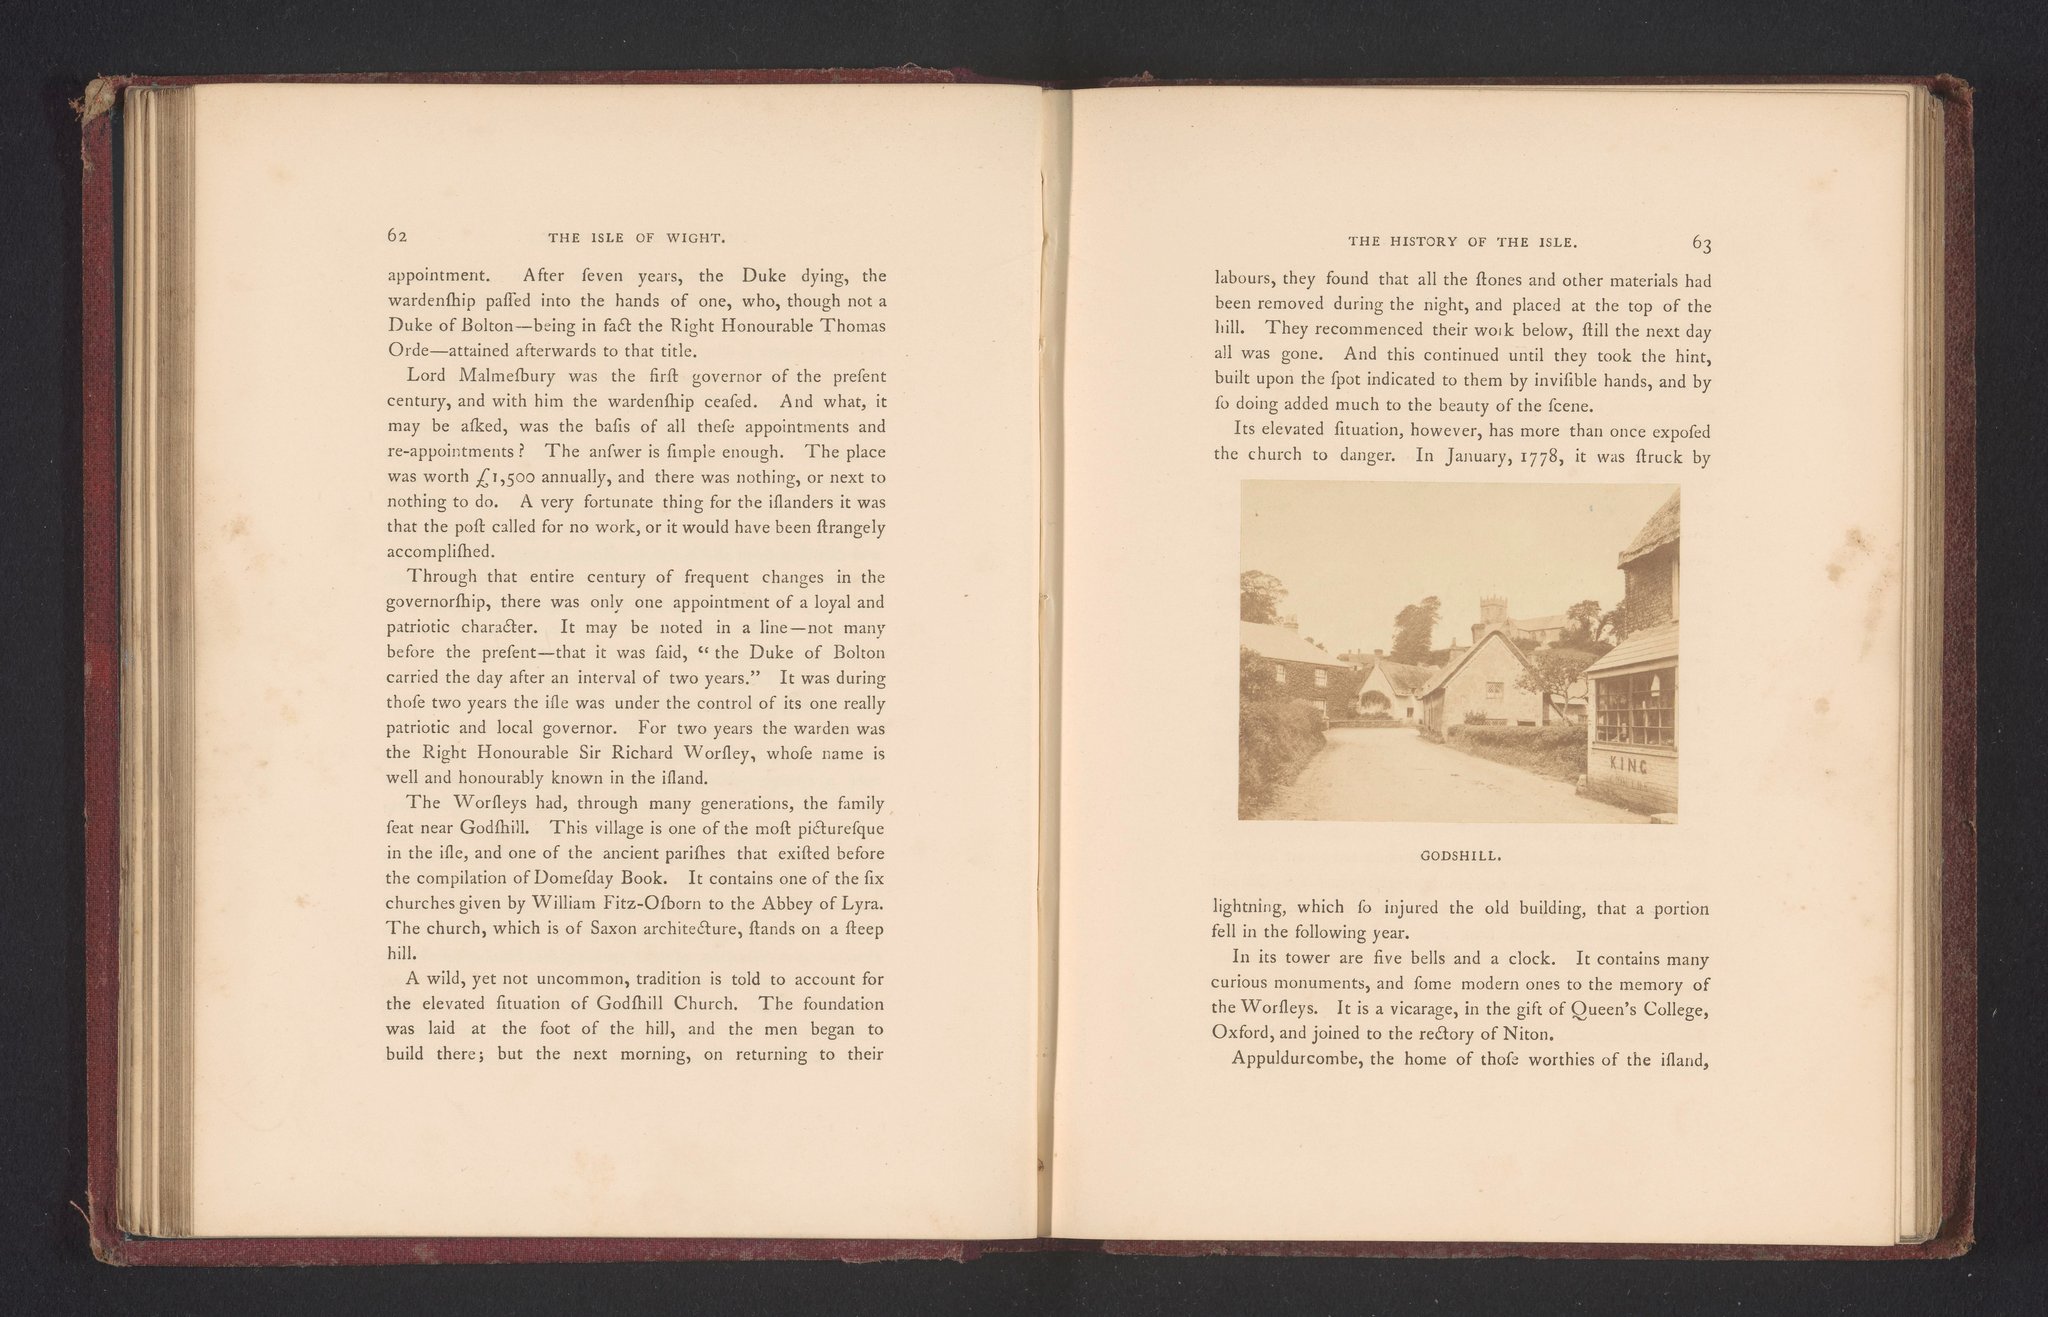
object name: page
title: Godshill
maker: william russell sedgfield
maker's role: fotograaf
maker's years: 1826-1902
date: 1859-1869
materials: photographic support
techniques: albumen print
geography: godshill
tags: façade (of house or building), street